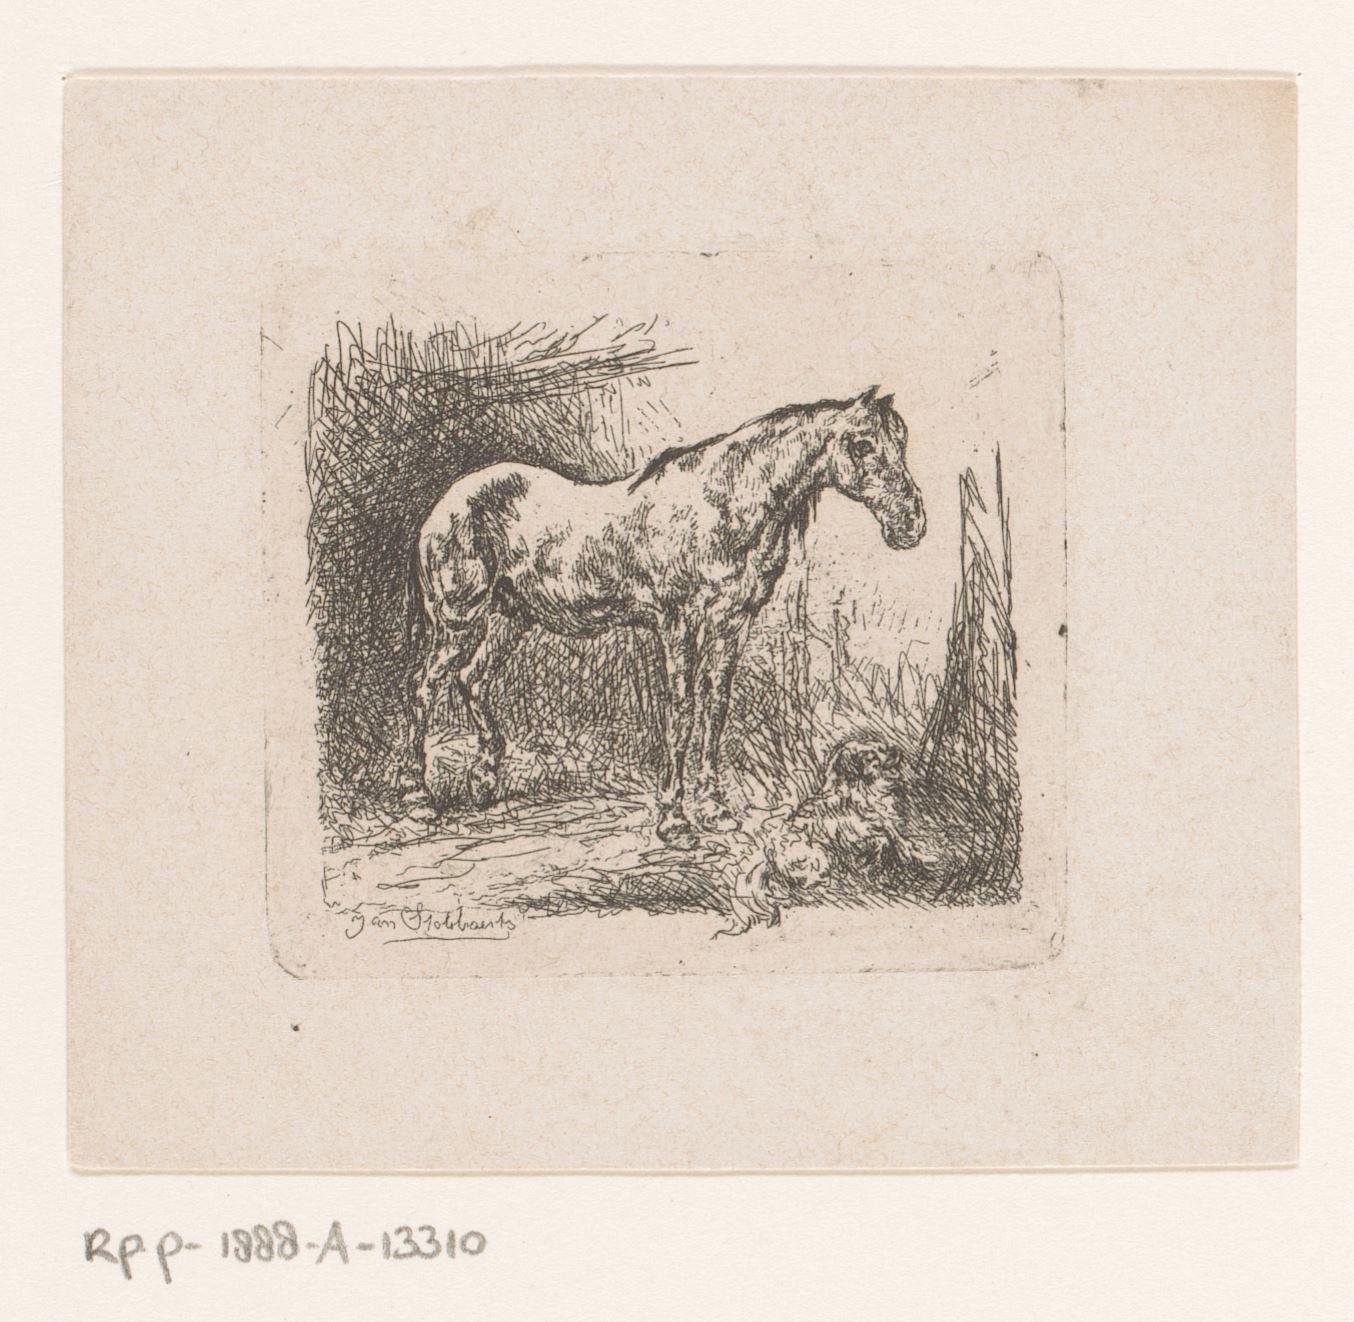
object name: print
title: Paard en een hond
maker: jan stobbaerts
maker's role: draughtsman, print maker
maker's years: 1838-1914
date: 1848-1879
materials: paper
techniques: etching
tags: horse, dog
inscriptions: collector's mark: Lugt 2228